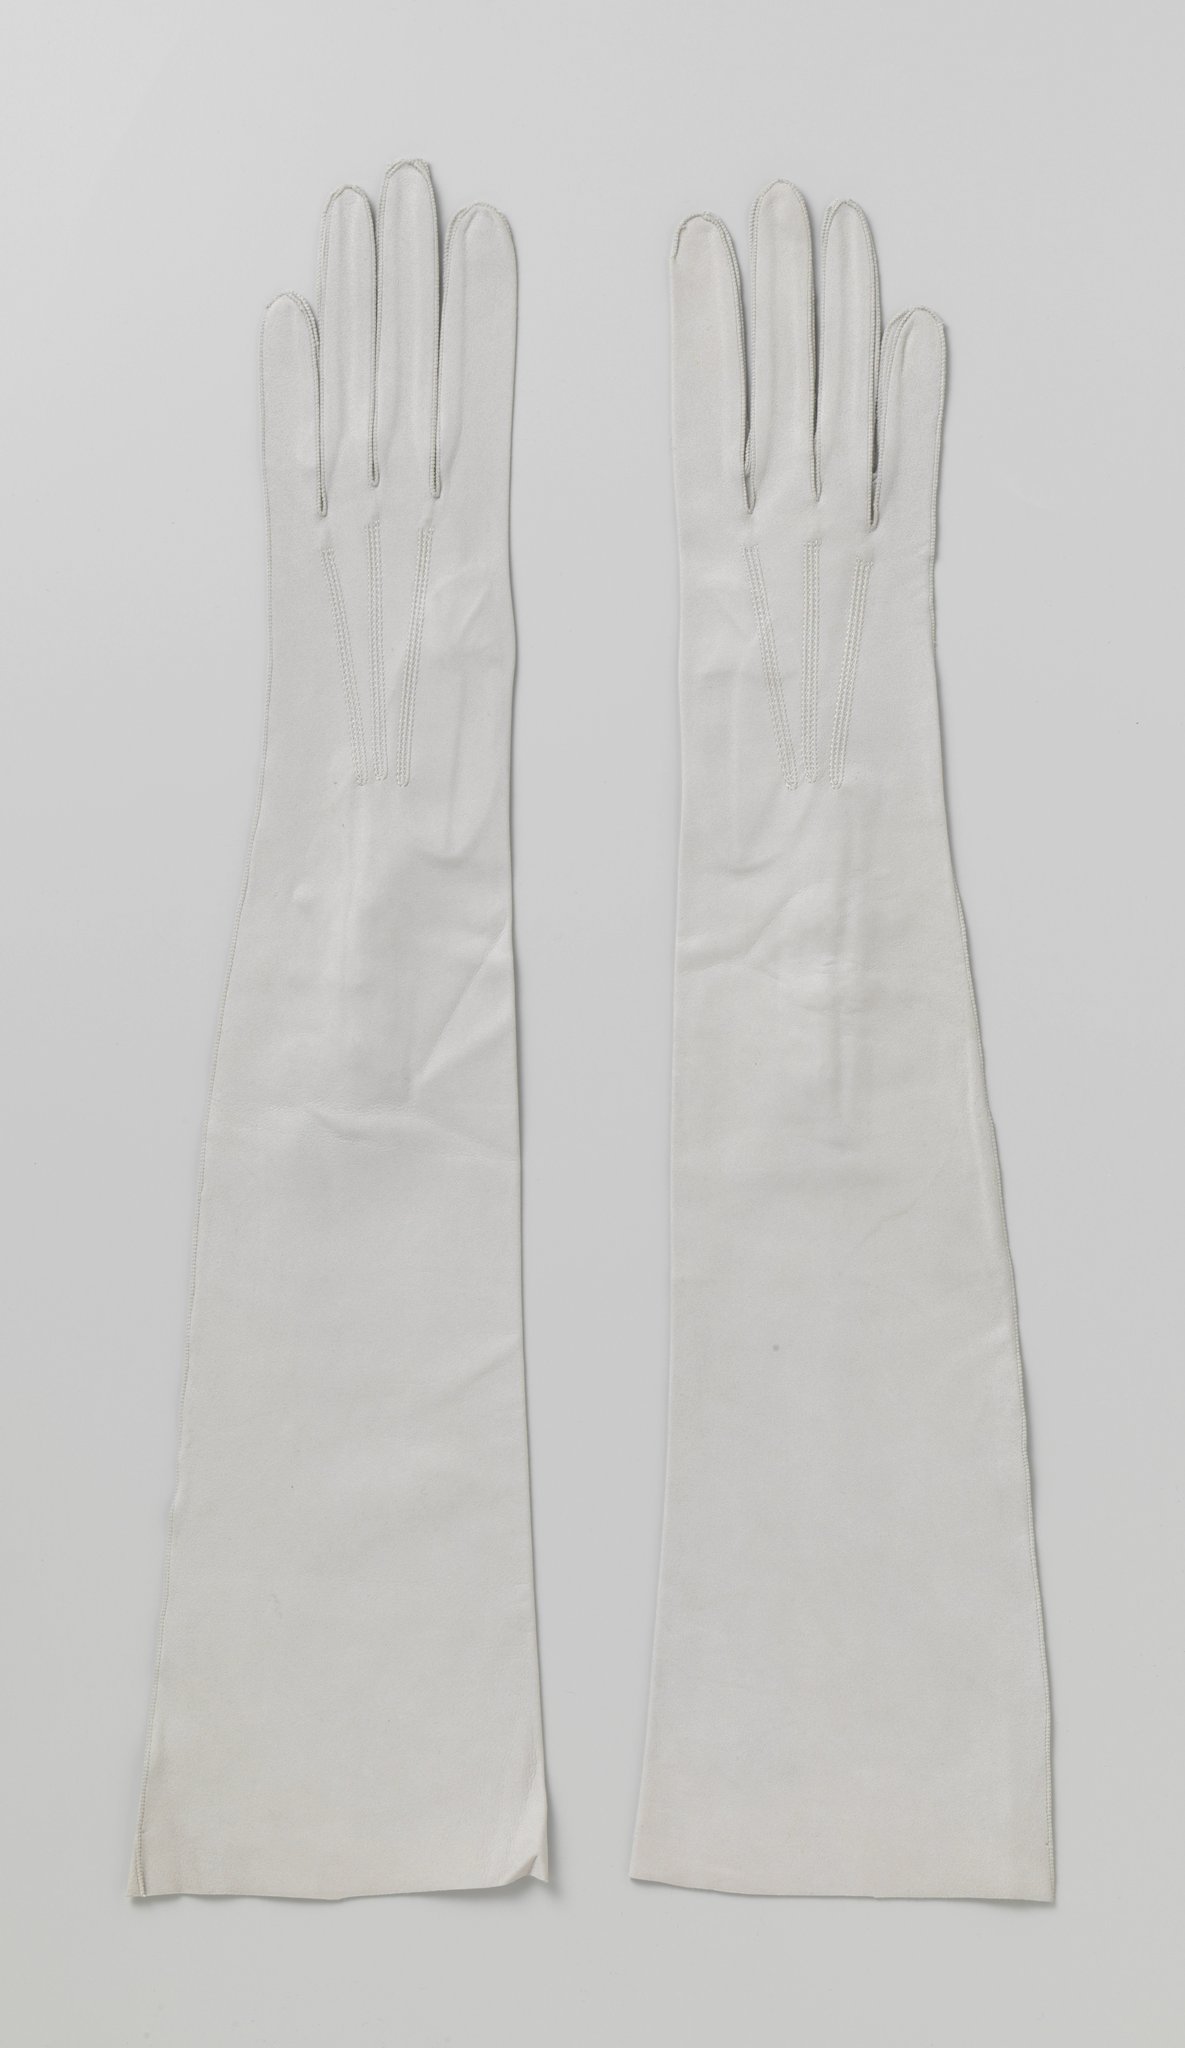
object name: glove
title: Pair of long gloves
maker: Anonymous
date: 1900-1915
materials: leather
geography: netherlands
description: Linker handschoenen van grijs wasleer. Op de hand drie uitstralende koorden. Bij de pols een split met drie parelmoerkleurige knopen.